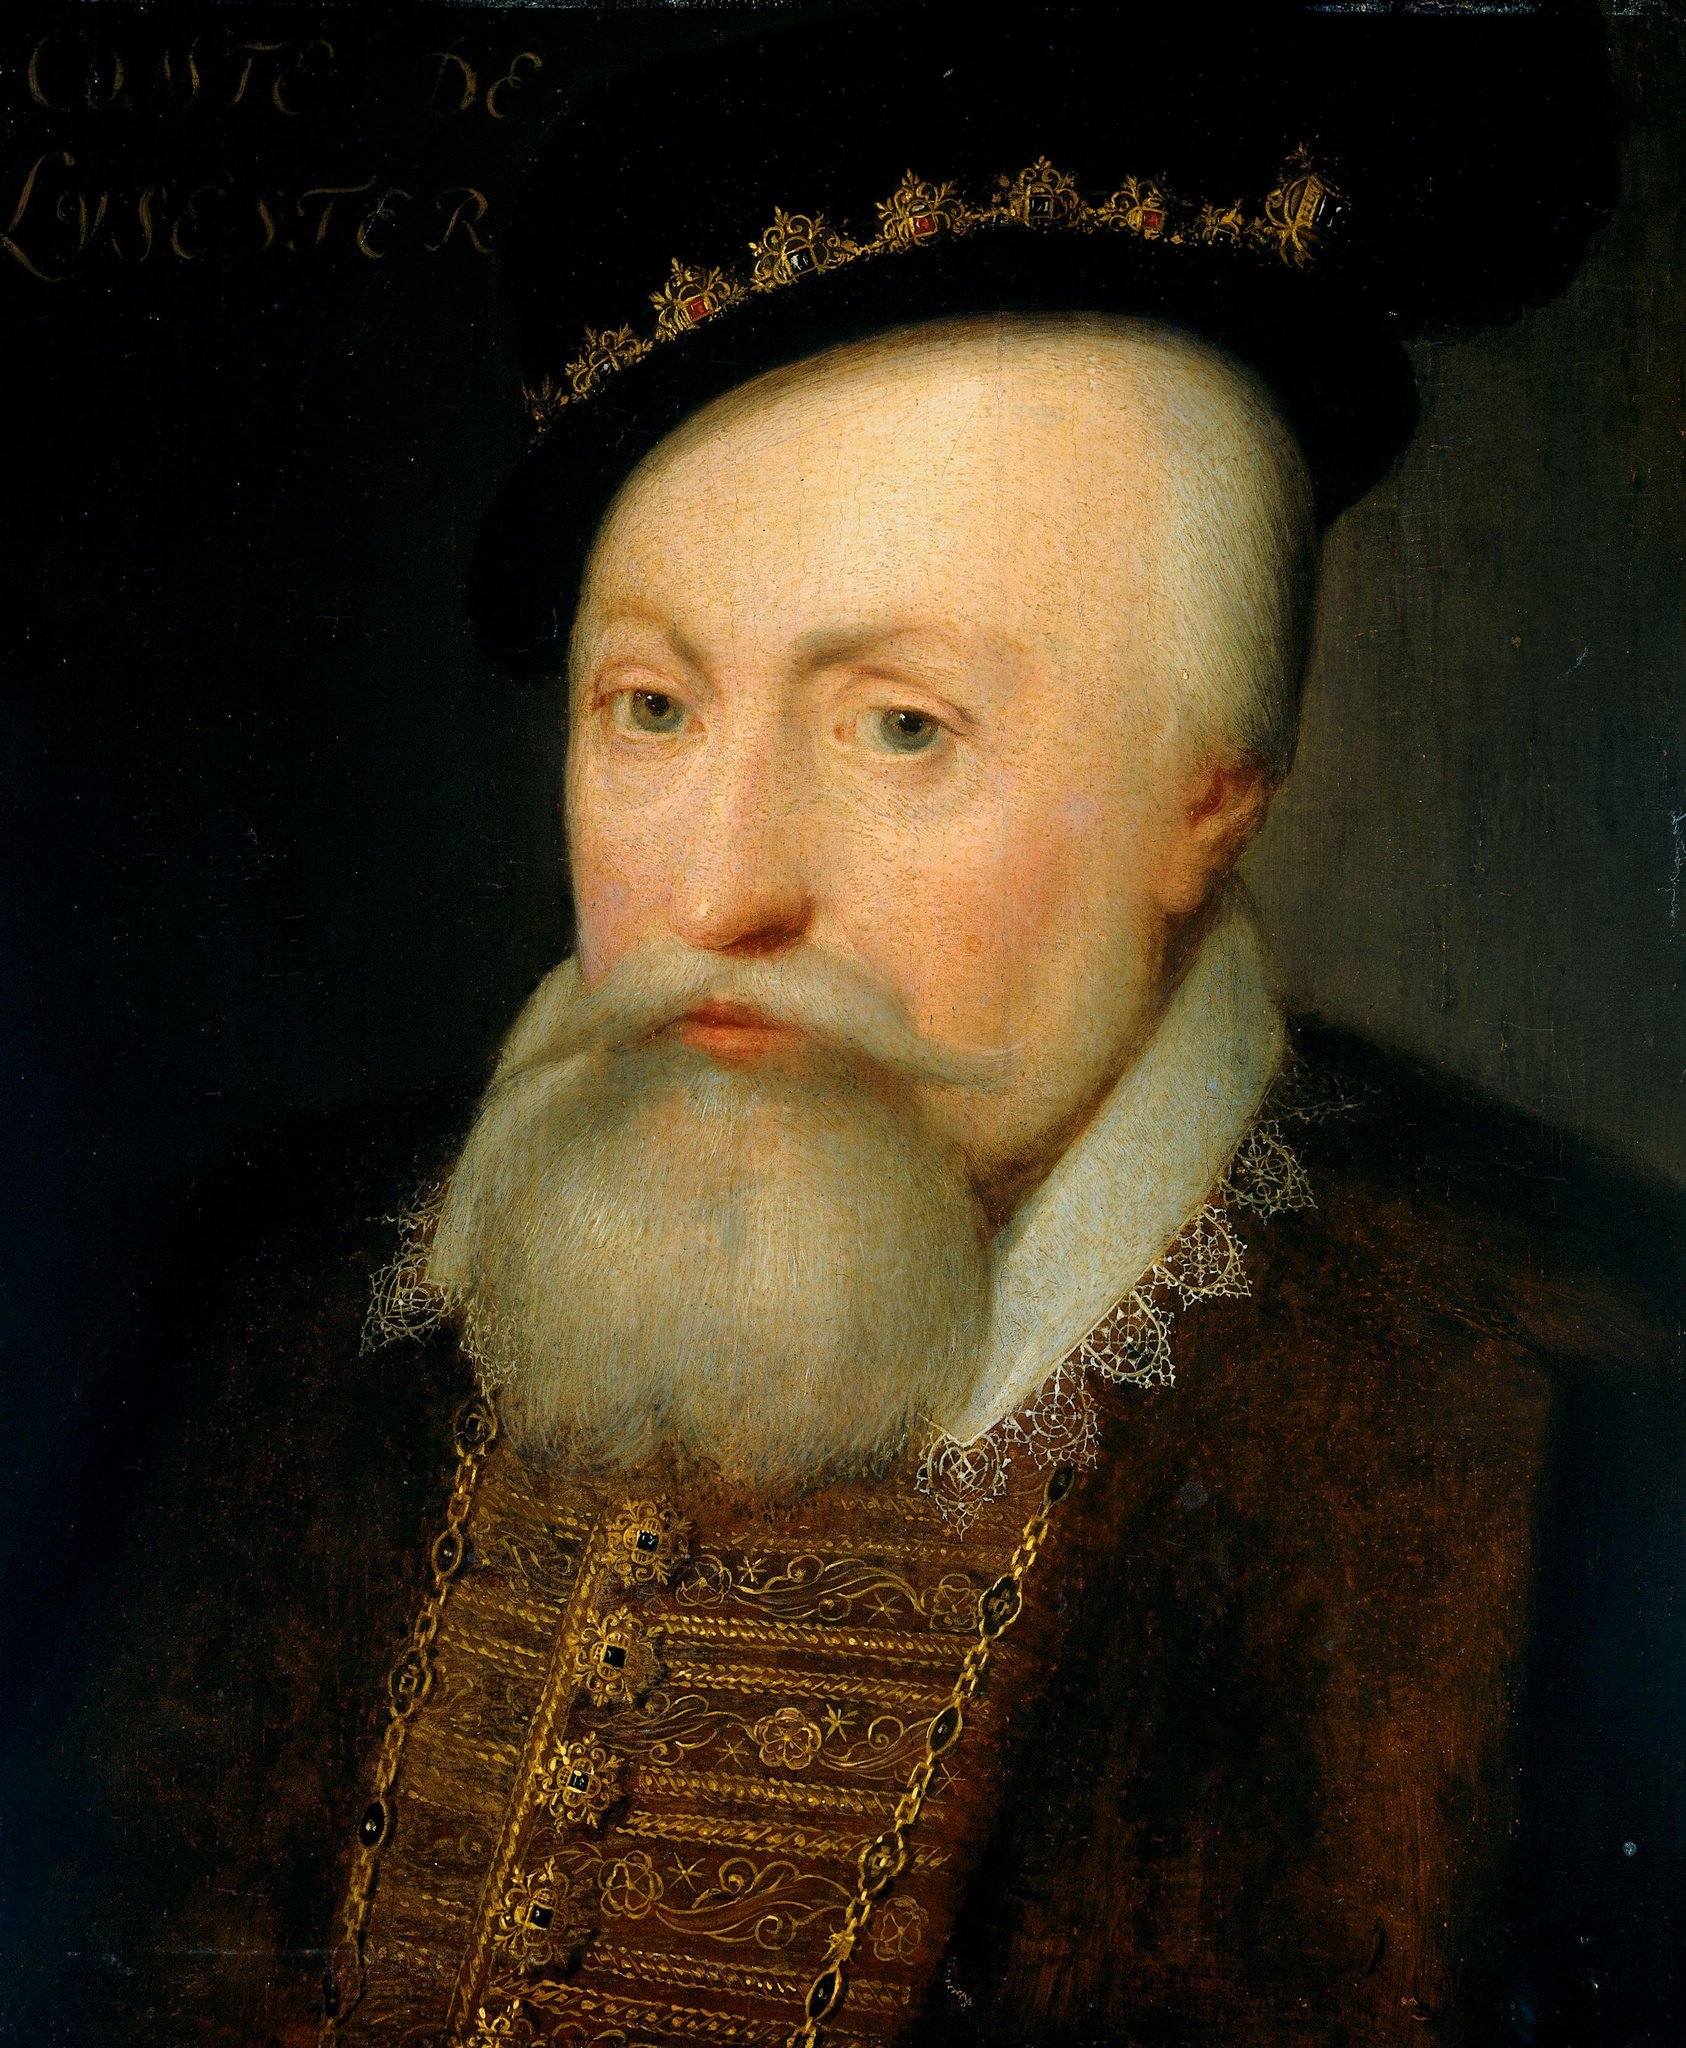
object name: painting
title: Portrait of Robert Dudley (1532-88), Earl of Leicester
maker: jan antonisz van ravesteyn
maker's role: draughtsman, painter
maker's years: 1570-1657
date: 1609-1633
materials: oil, panel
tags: robert dudley (1st earl of leicester), historical persons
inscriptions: inscription, upper left: ‘Comte de Lysester’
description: Military leaders of the Eighty Years War. These portraits were originally displayed at Honselaarsdijk, the palace built by Stadholder Frederick Henry and his wife Amalia in the 1620s near The Hague. In the style of European courts of the day, one of the palace rooms was lined with portraits of ancestors, relatives and celebrities past and present. Many of these personalities played a role in the Eighty Years War: members of the Nassau family and other commanders of the Dutch Republic's army, officers of the French and English allies and leading Spanish generals. A remarkable aspect is the number of foreigners who fought for the Dutch. The Republic's army enjoyed an international reputation and attracted young noblemen from abroad. For them, the war was a career opportunity.